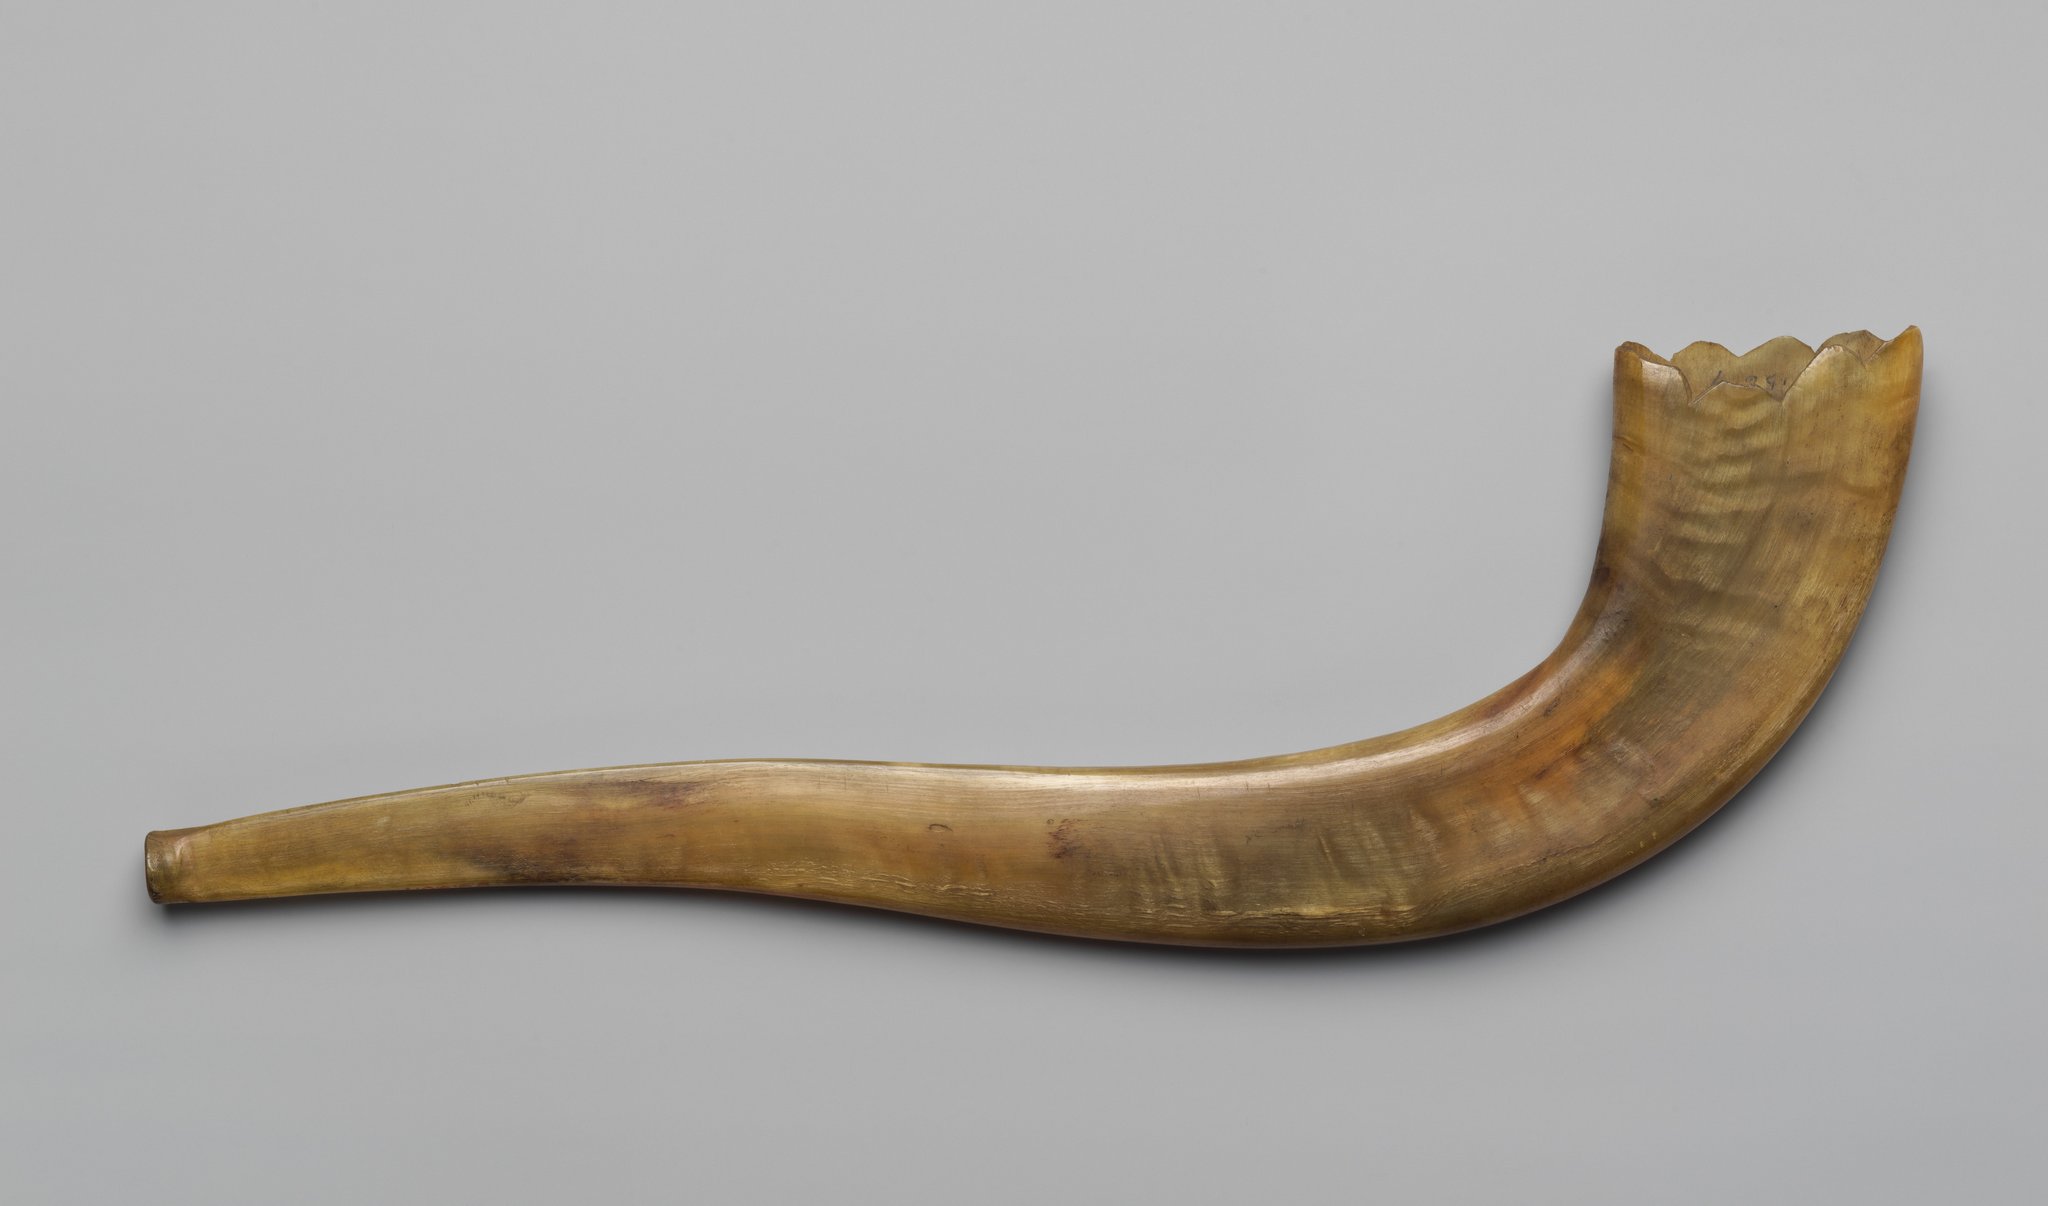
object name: shofar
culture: jewish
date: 1850-1946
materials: horn